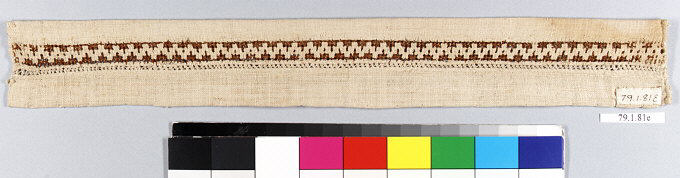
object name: strip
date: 1501-1600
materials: linen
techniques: embroidery